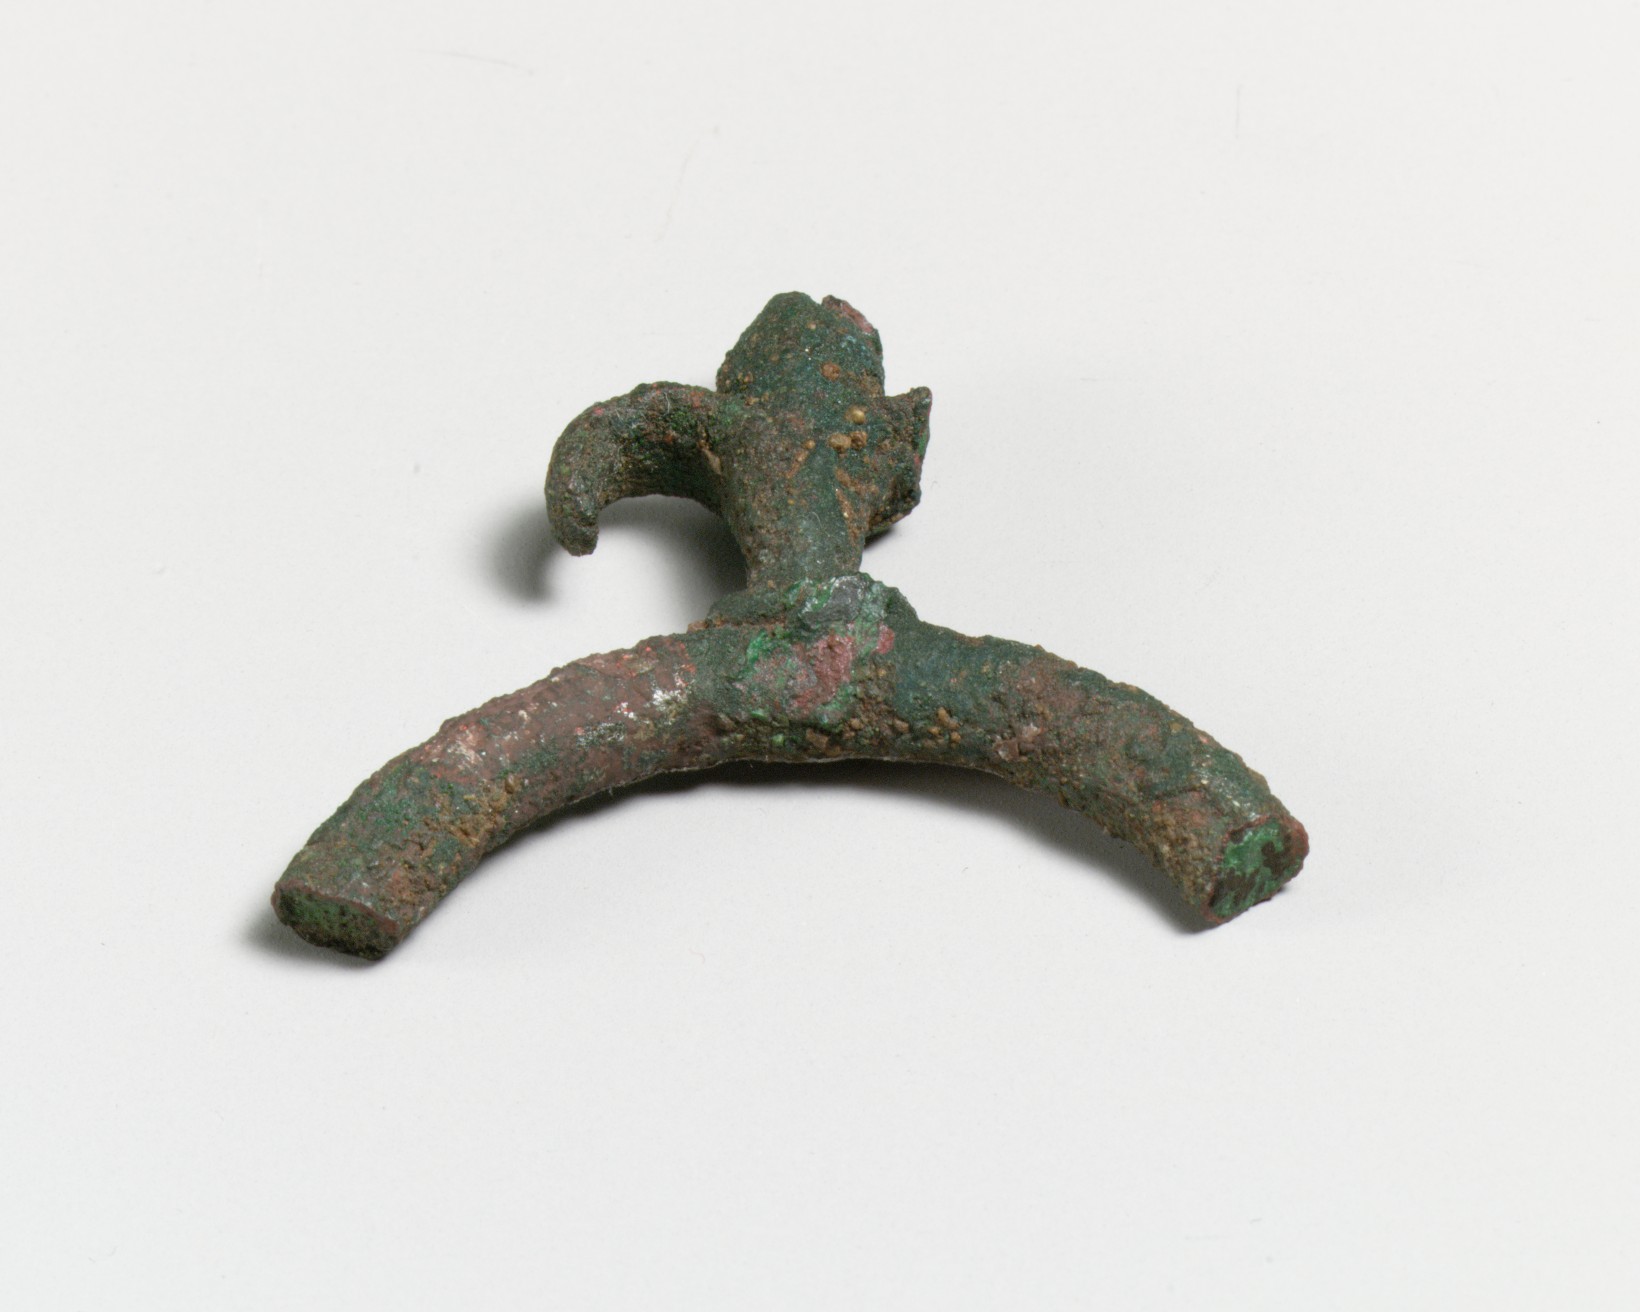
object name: handle of a bowl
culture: cypriot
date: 700-501 BCE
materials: bronze